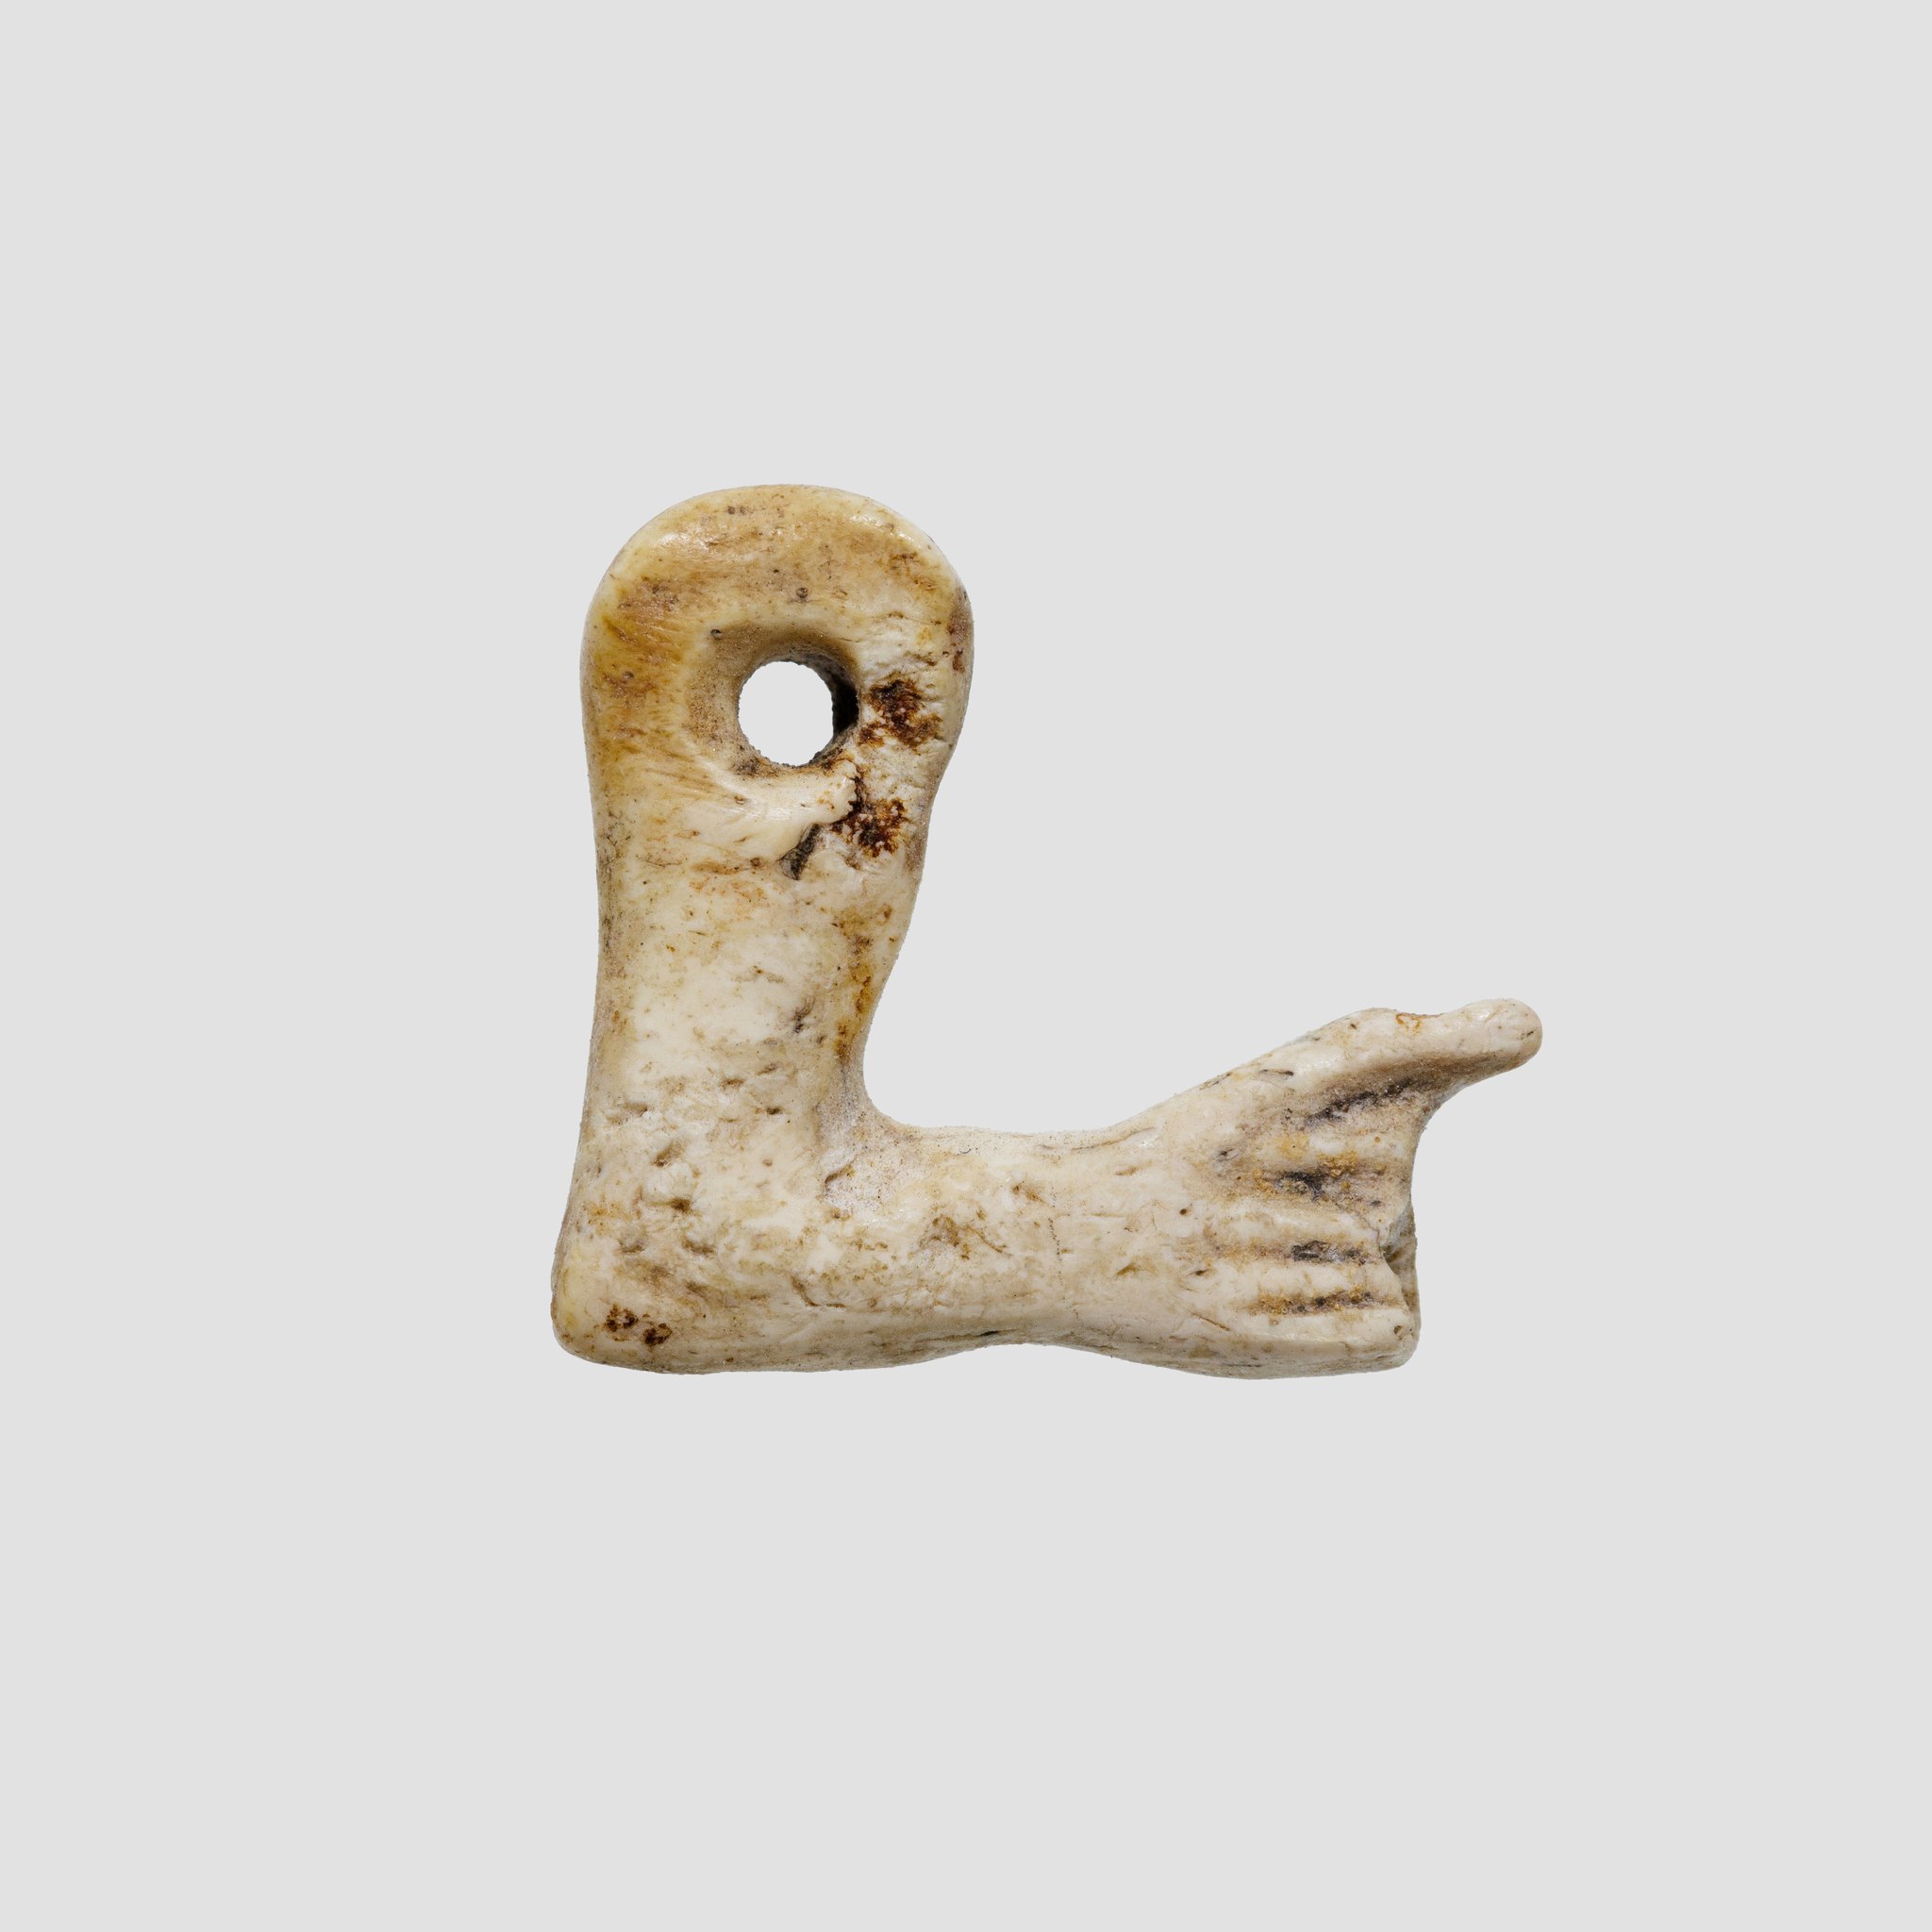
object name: amulet, arm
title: Arm amulet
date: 2150-1950 BCE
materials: bone, ivory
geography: egypt